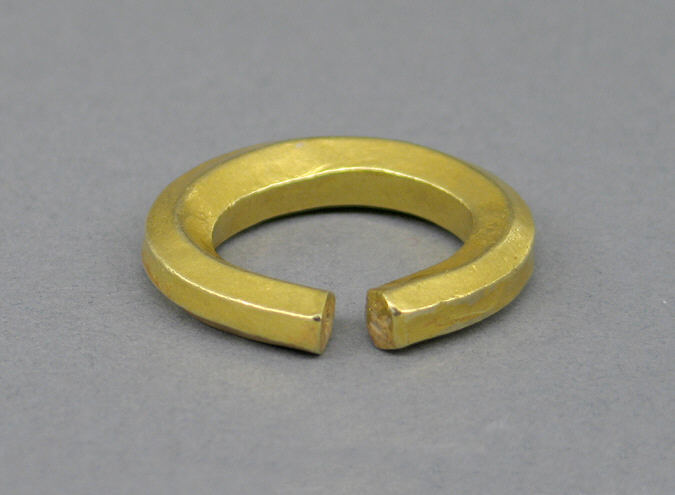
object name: ear ornament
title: Oblong-Shaped Ear Ornament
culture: indonesian, javanese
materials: gold